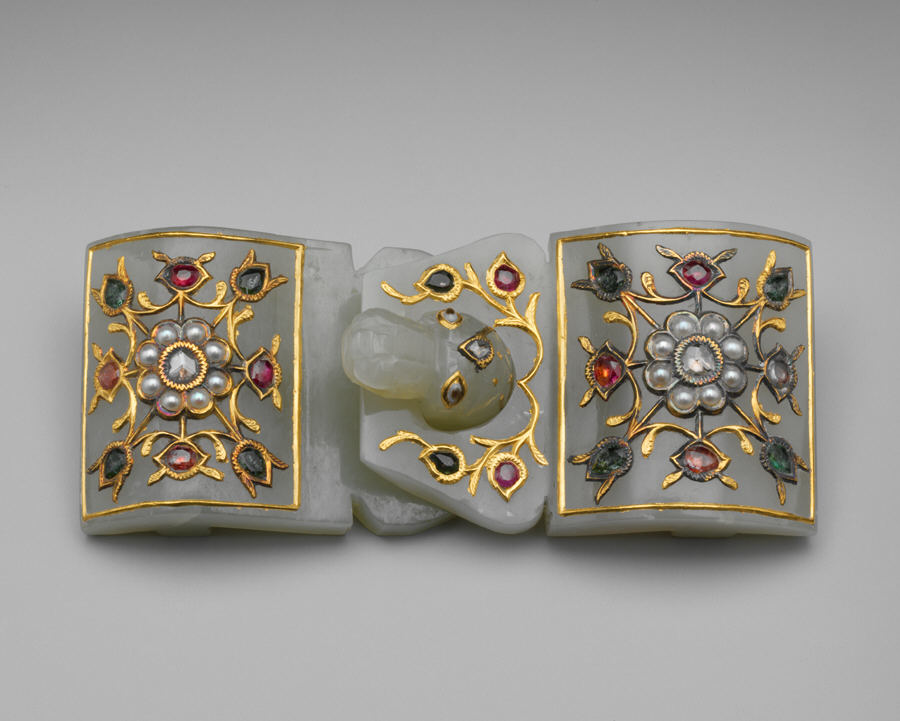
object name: belt buckle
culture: chinese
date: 1701-1900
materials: gold, jade, pearl, stone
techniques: inlay